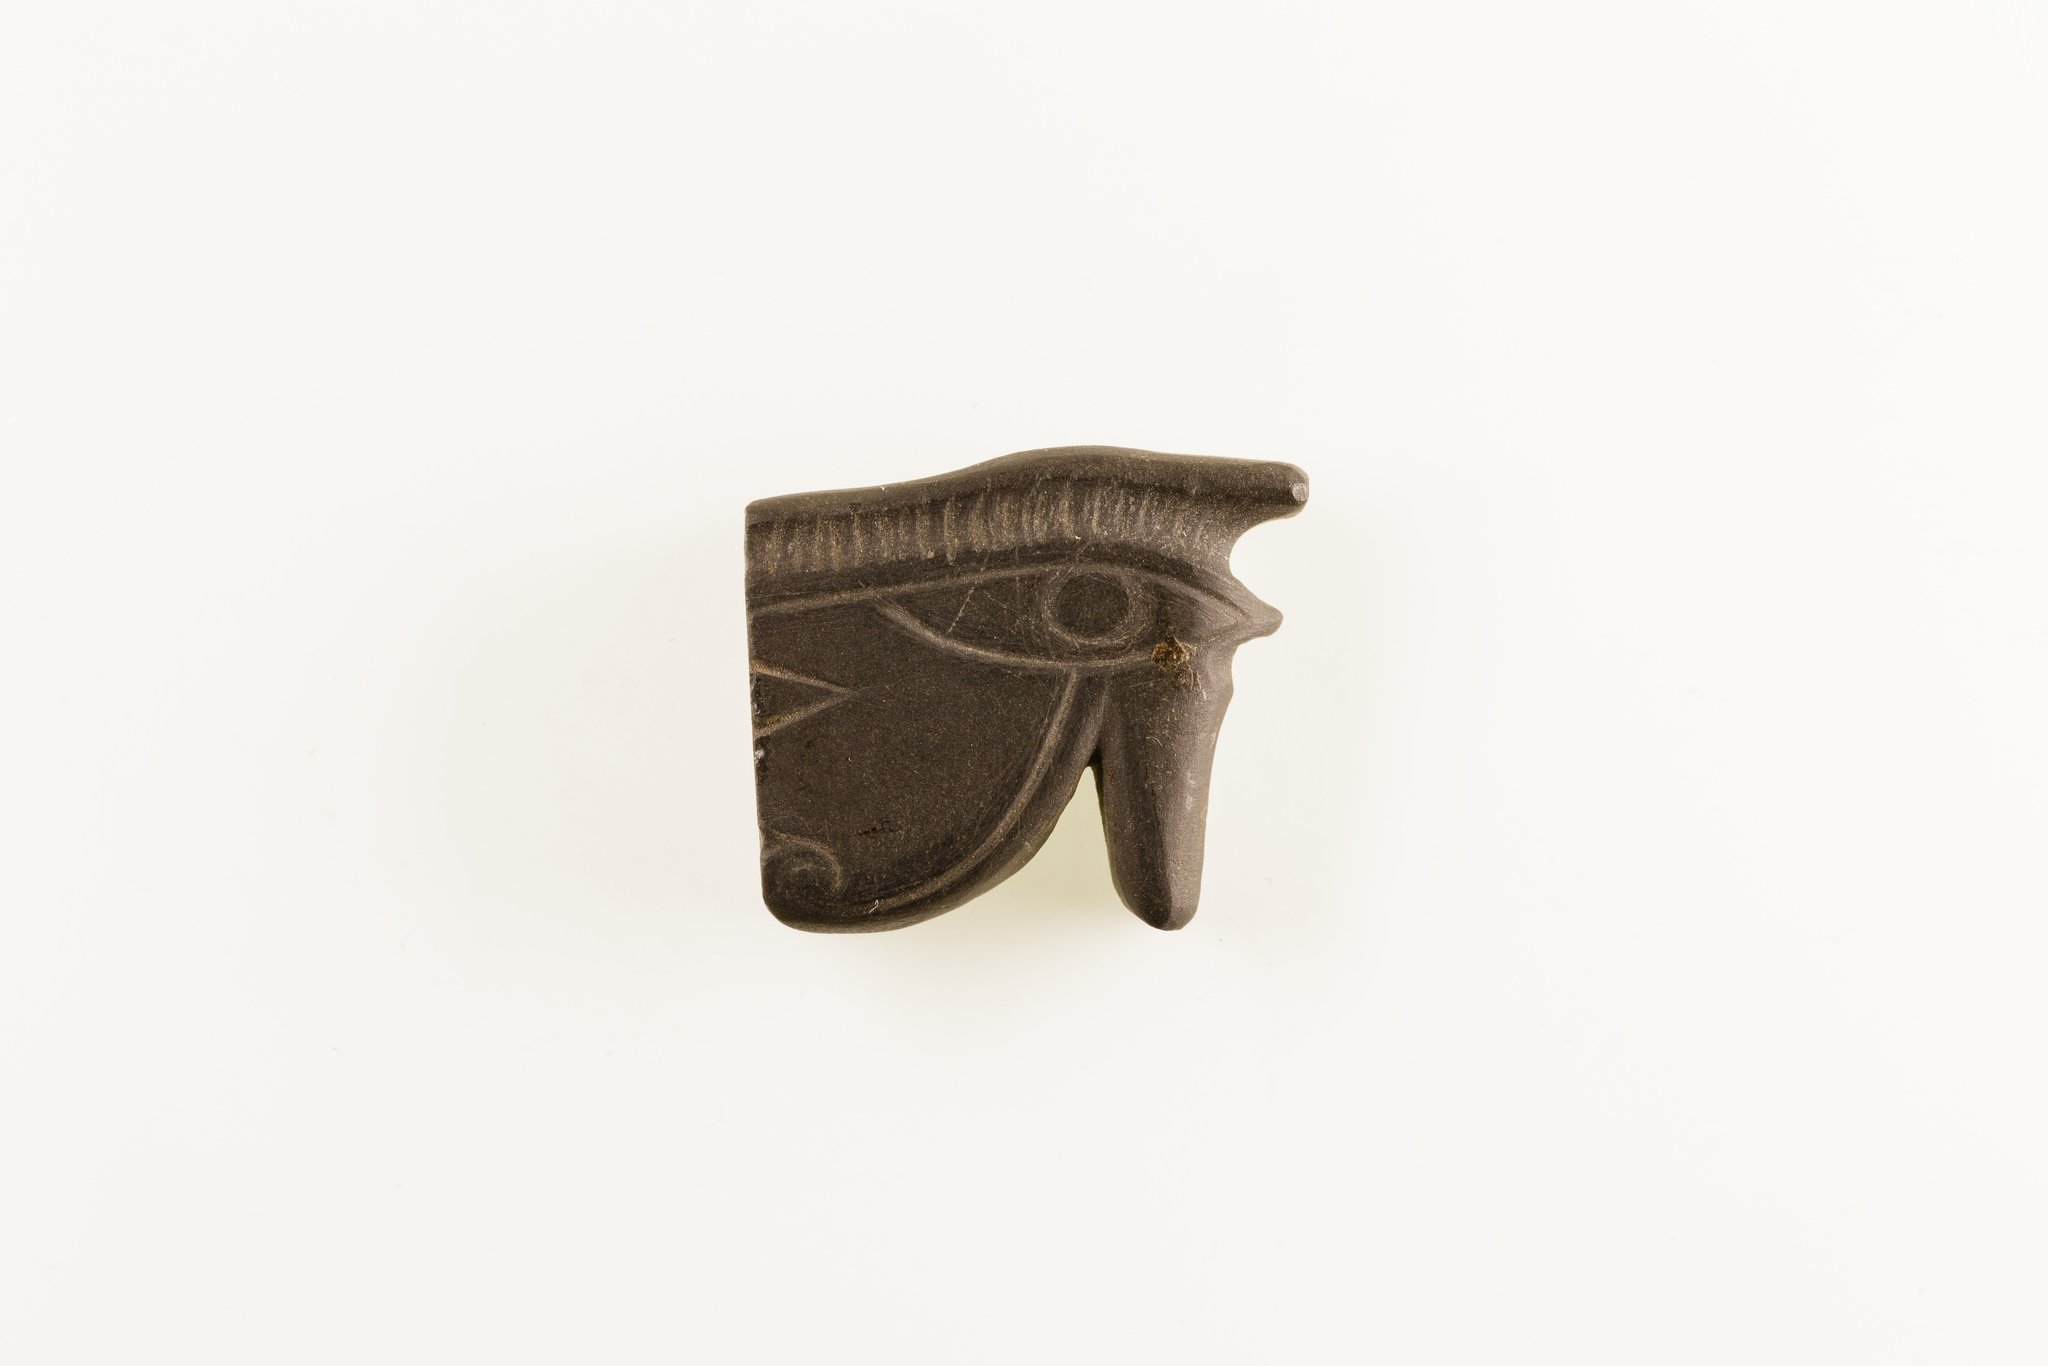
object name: inlay, wedjat eye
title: Wedjat eye inlay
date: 522-343 BCE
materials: glass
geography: egypt